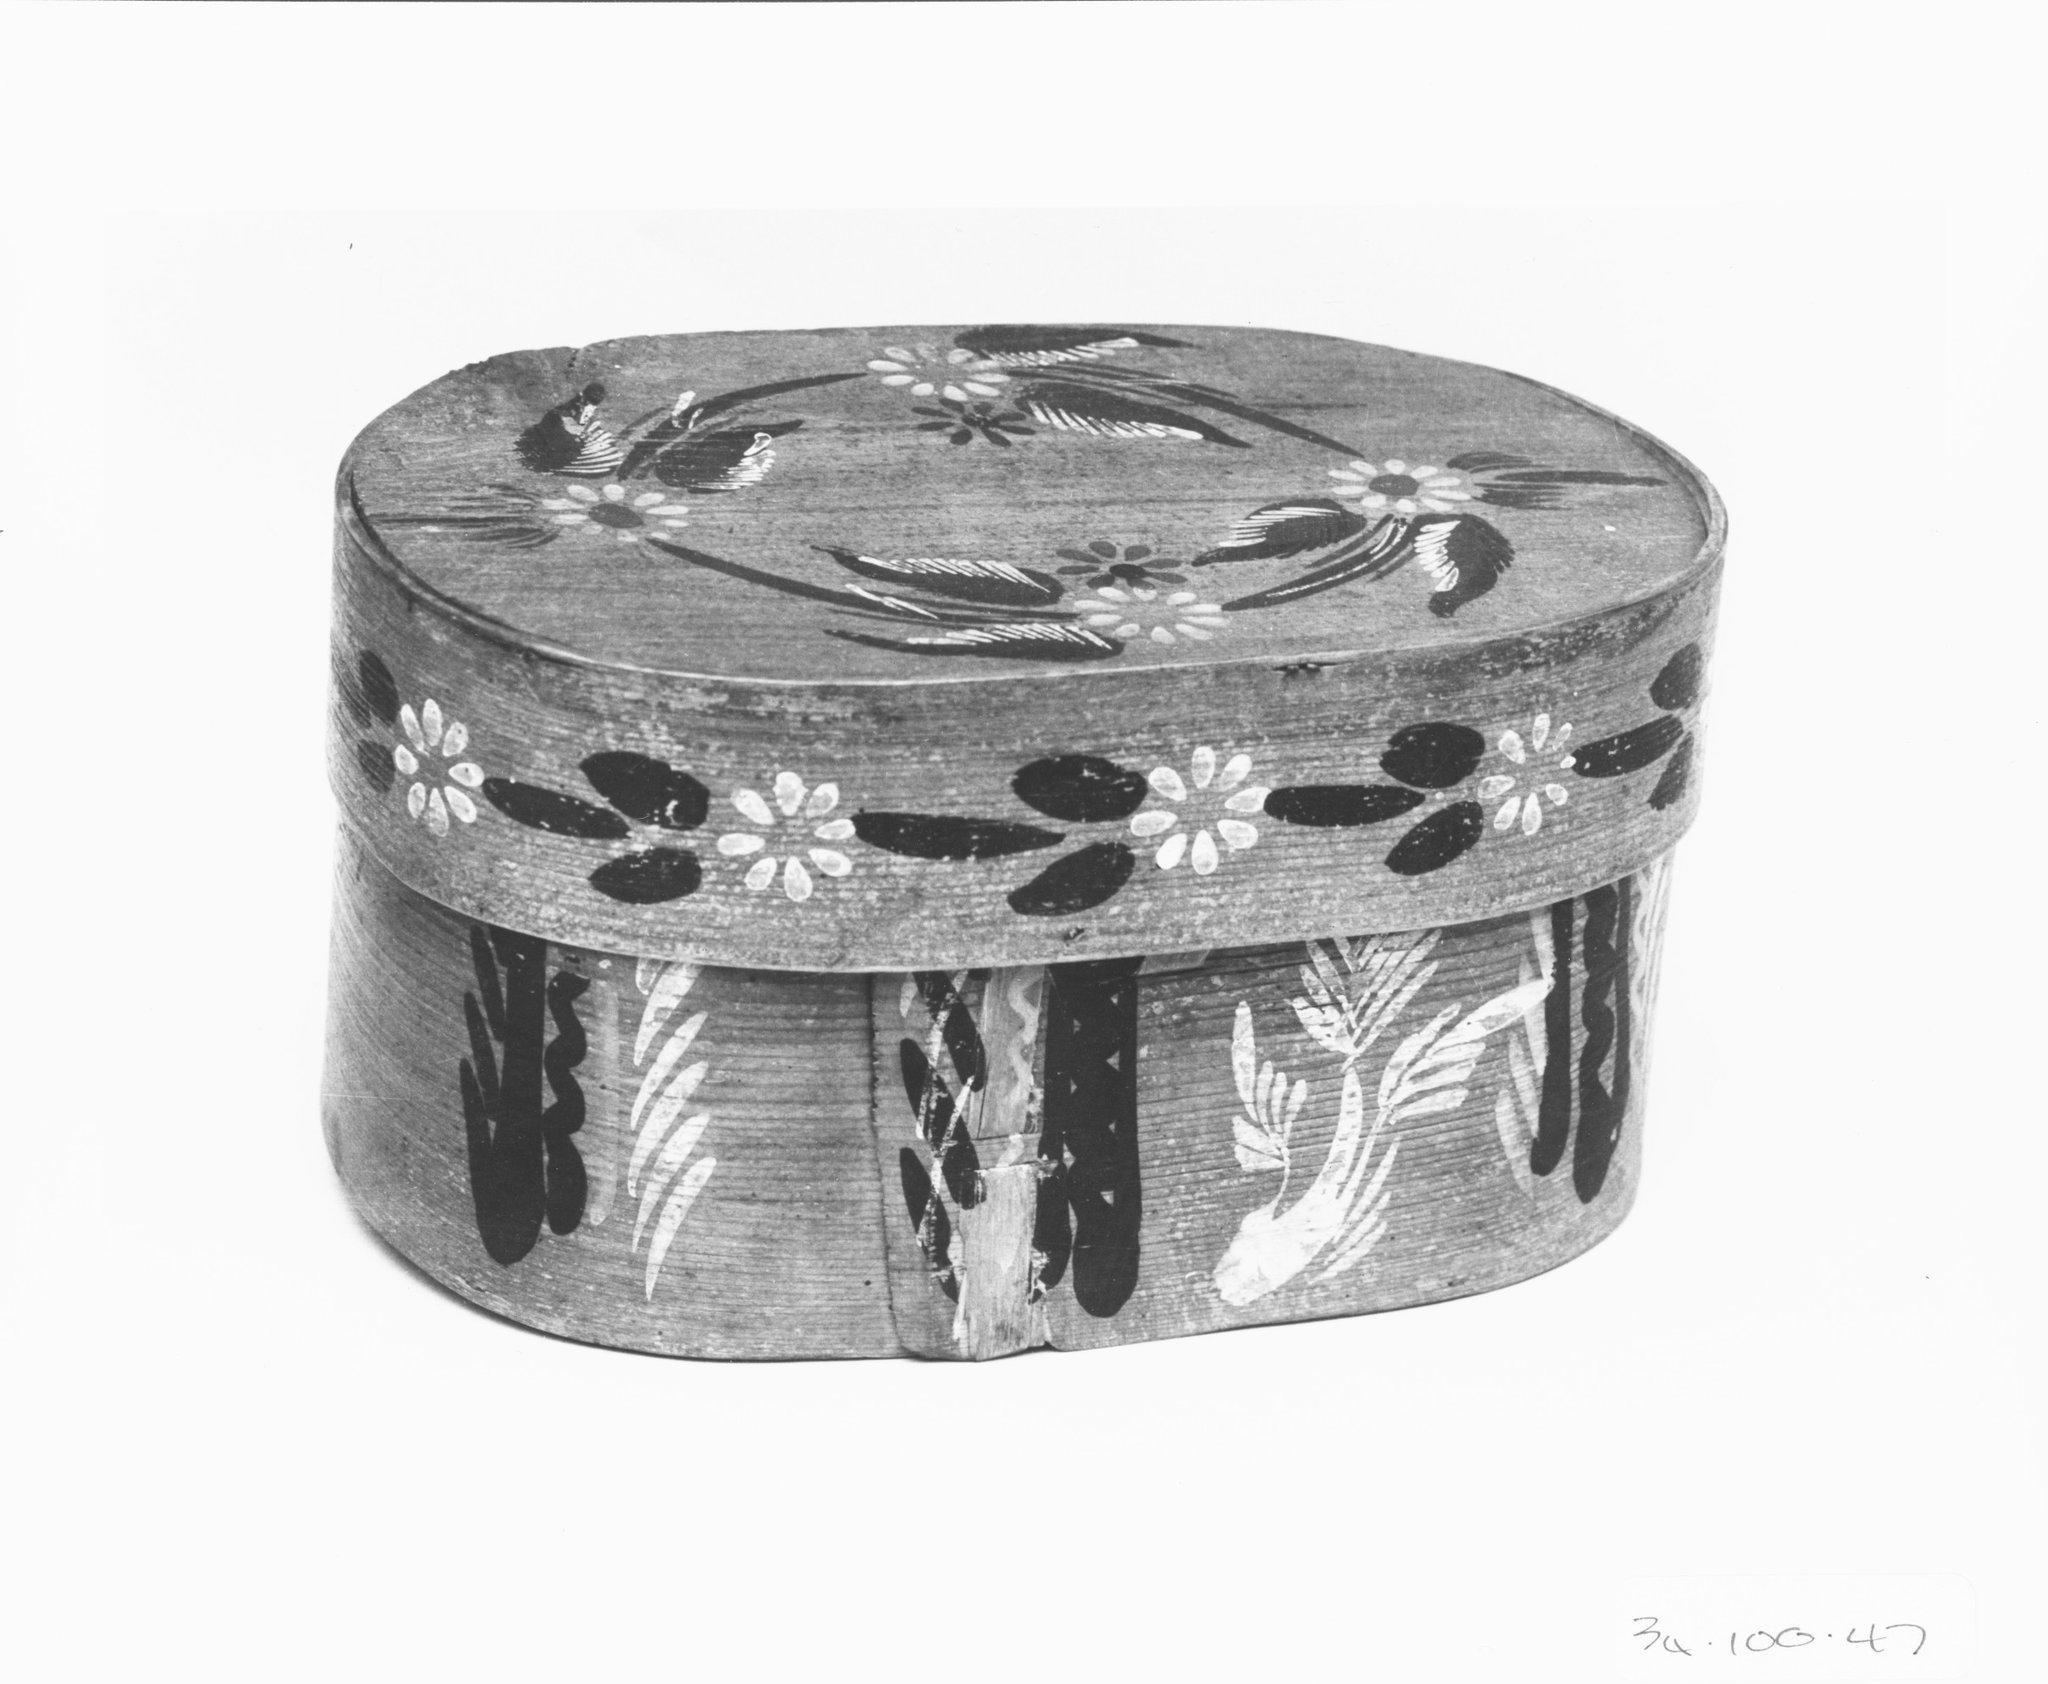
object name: trinket box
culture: american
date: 1770-1800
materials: wood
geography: united states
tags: flowers